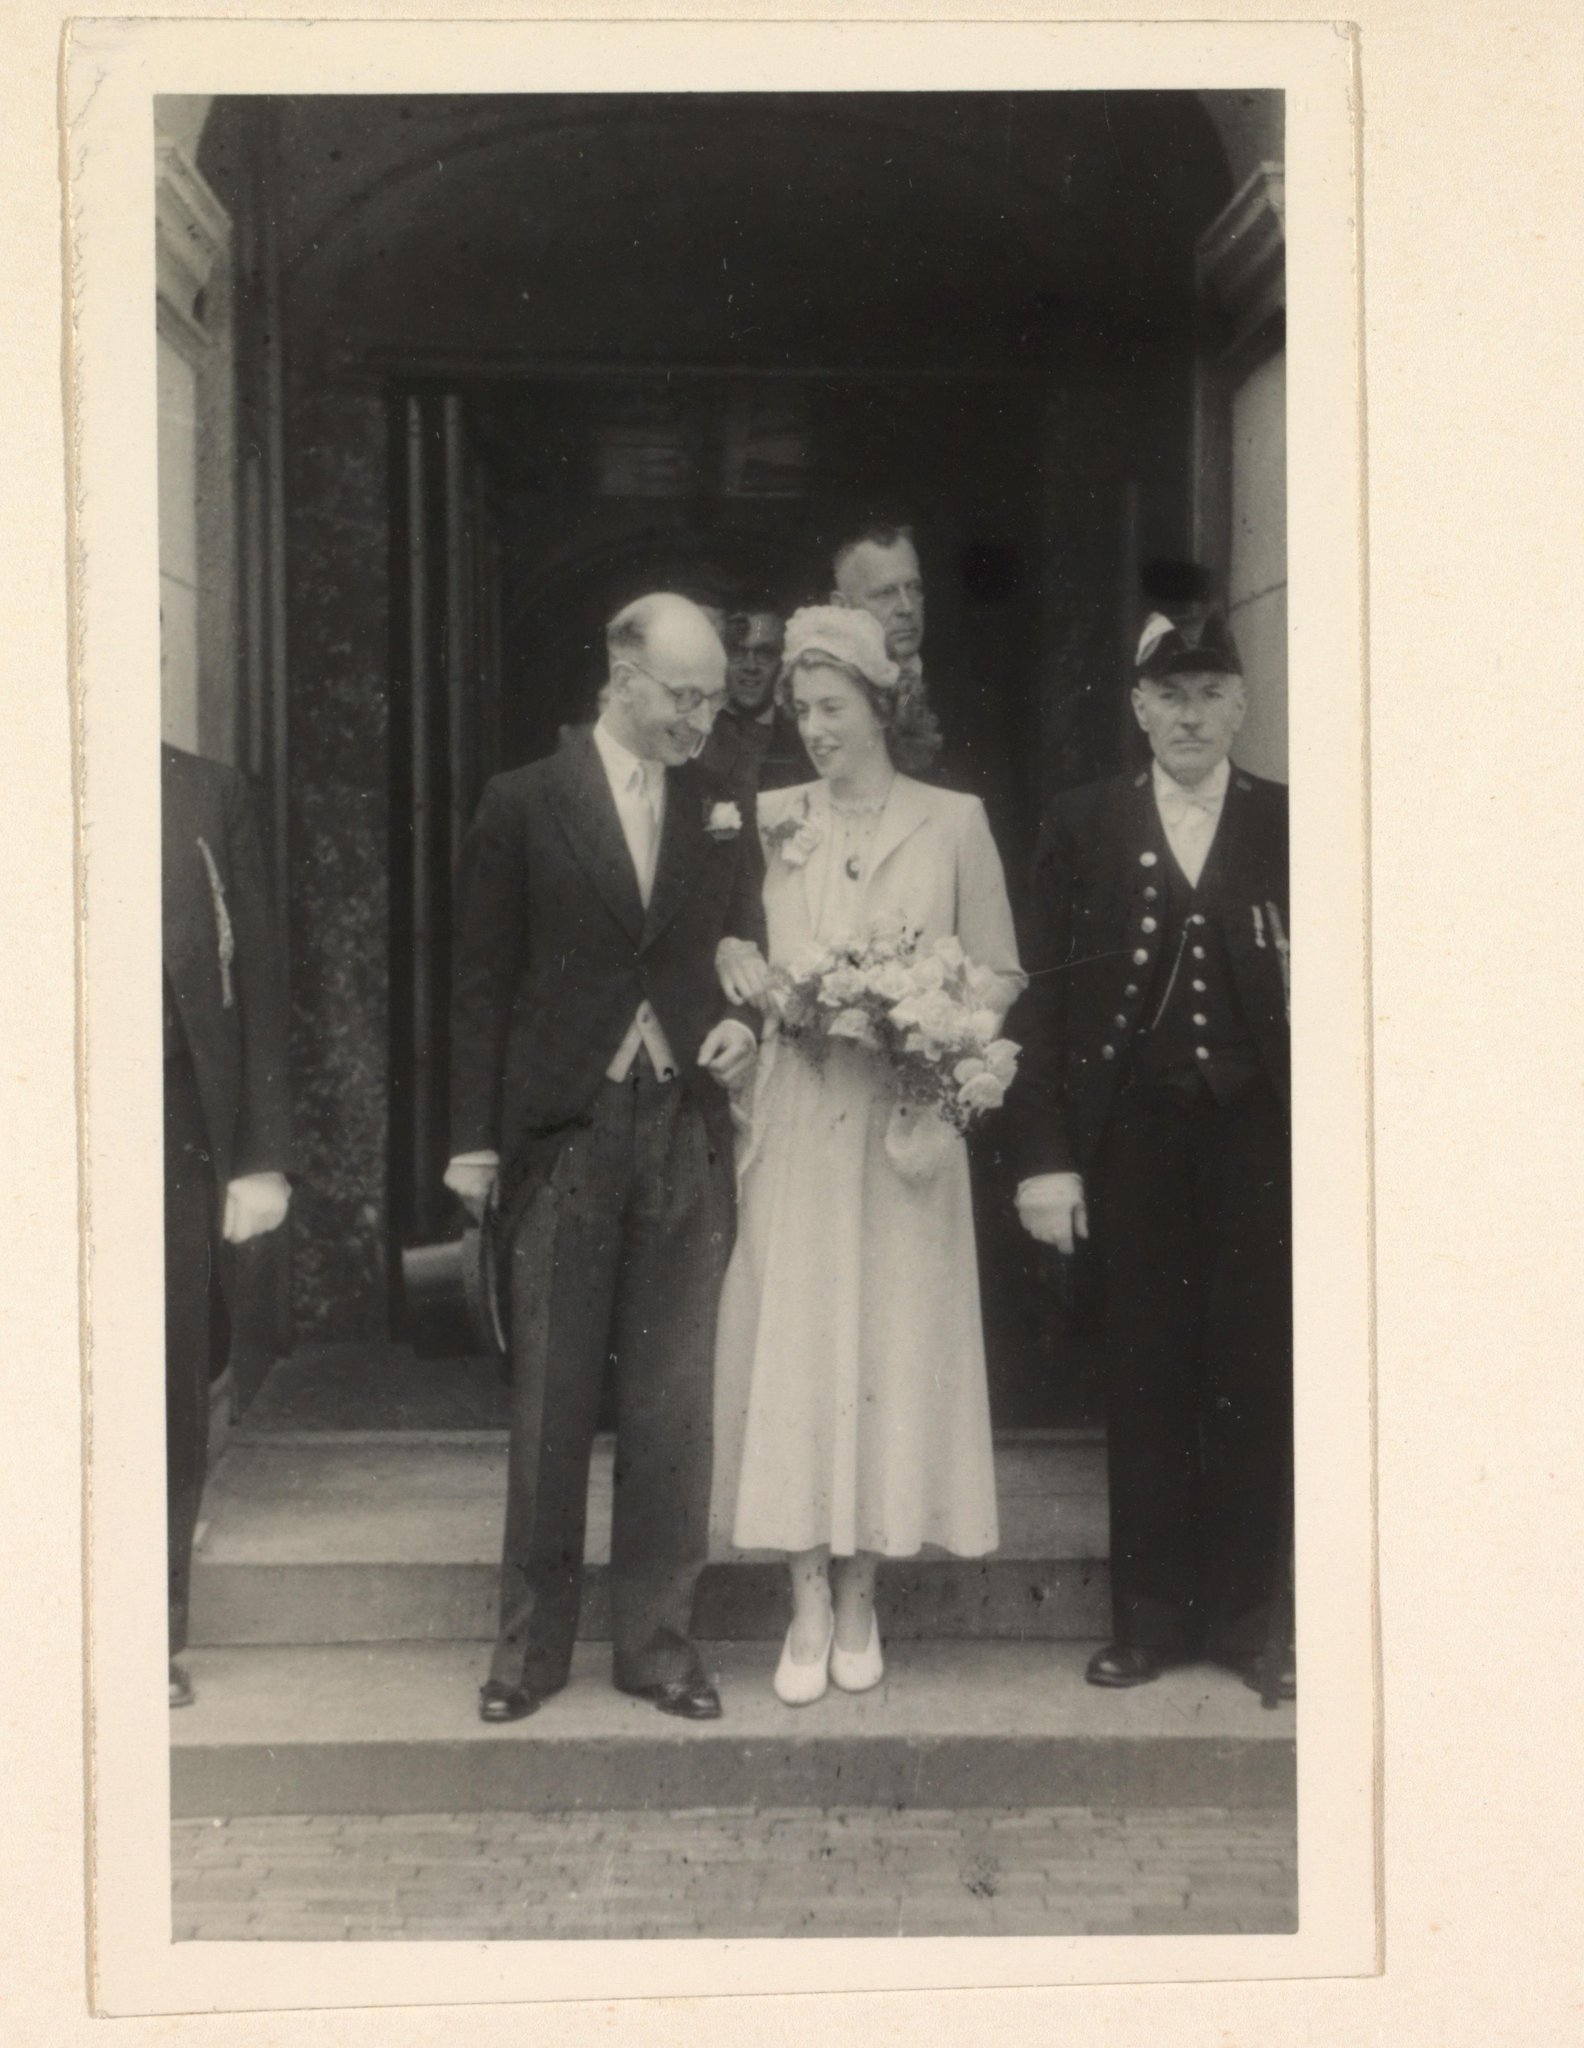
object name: photograph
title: Huwelijksportret van het echtpaar Feenstra-Von Saher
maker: joop colson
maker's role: fotograaf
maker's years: 1901-1966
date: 1948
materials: cardboard, photographic support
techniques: gelatin silver print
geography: amsterdam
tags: bride and groom in wedding-dress, amsterdam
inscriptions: inscription: ‘huwelijk Feenstra-von Saher’